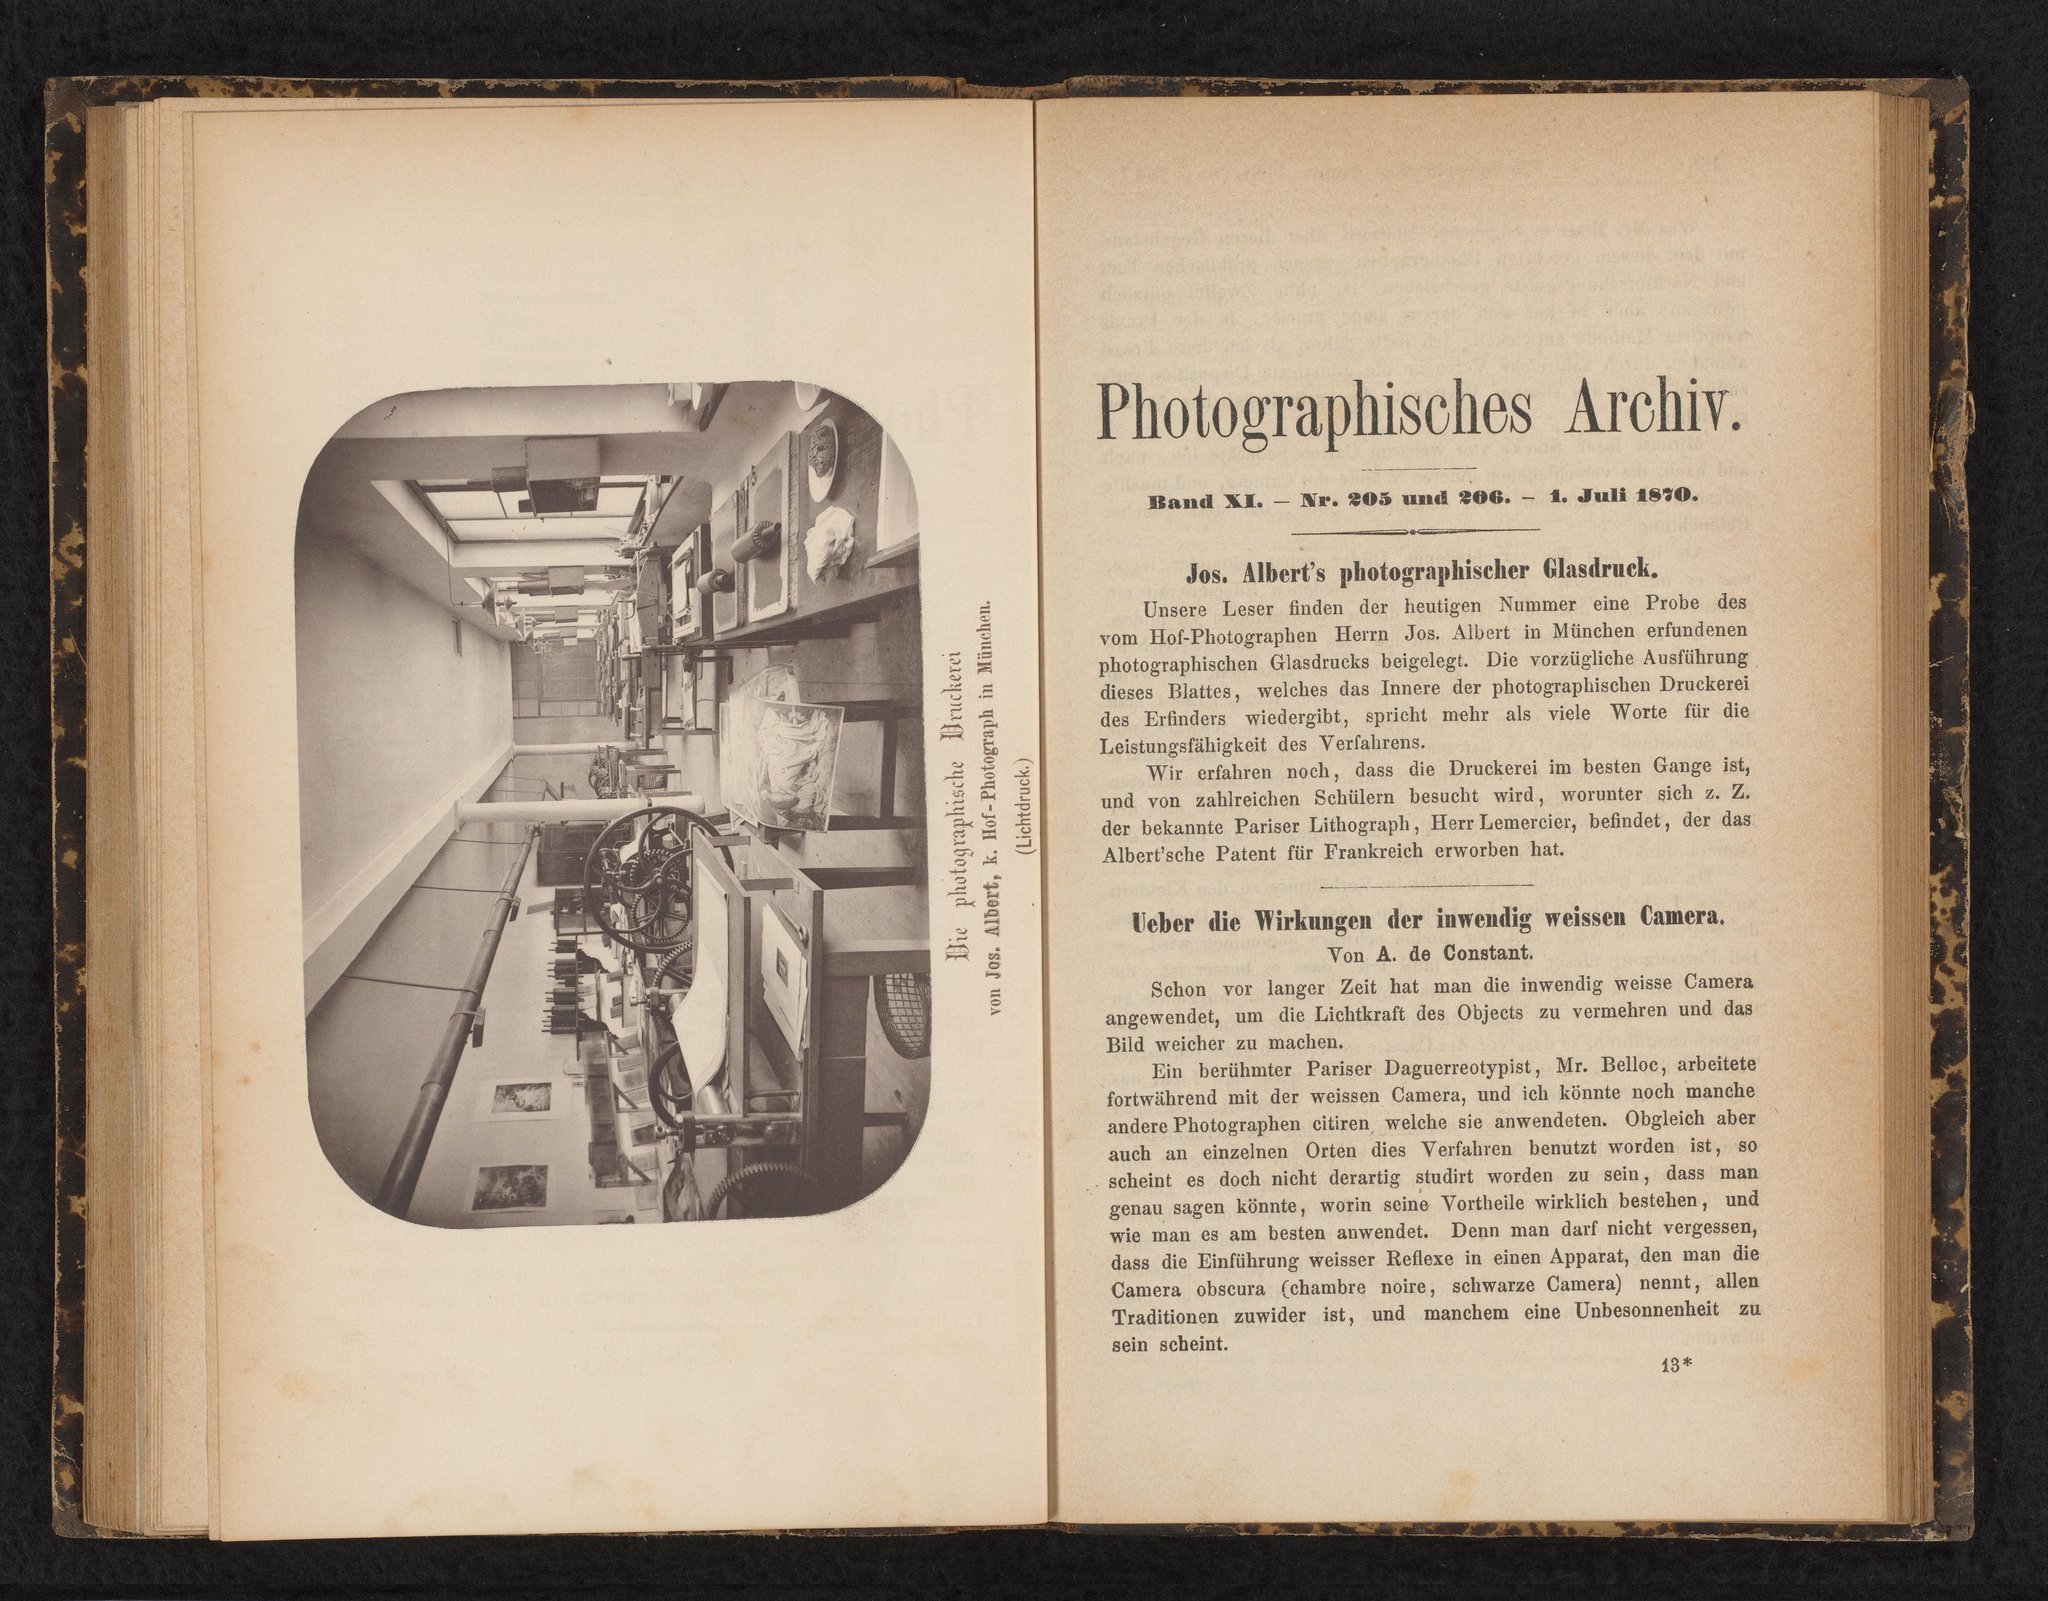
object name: page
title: Interieur van de drukkerij van Joseph Albert, München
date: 1865-1870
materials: paper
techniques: photograph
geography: munich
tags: printing, printing office, printer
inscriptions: inscription: ‘(Lichtdruck.)’